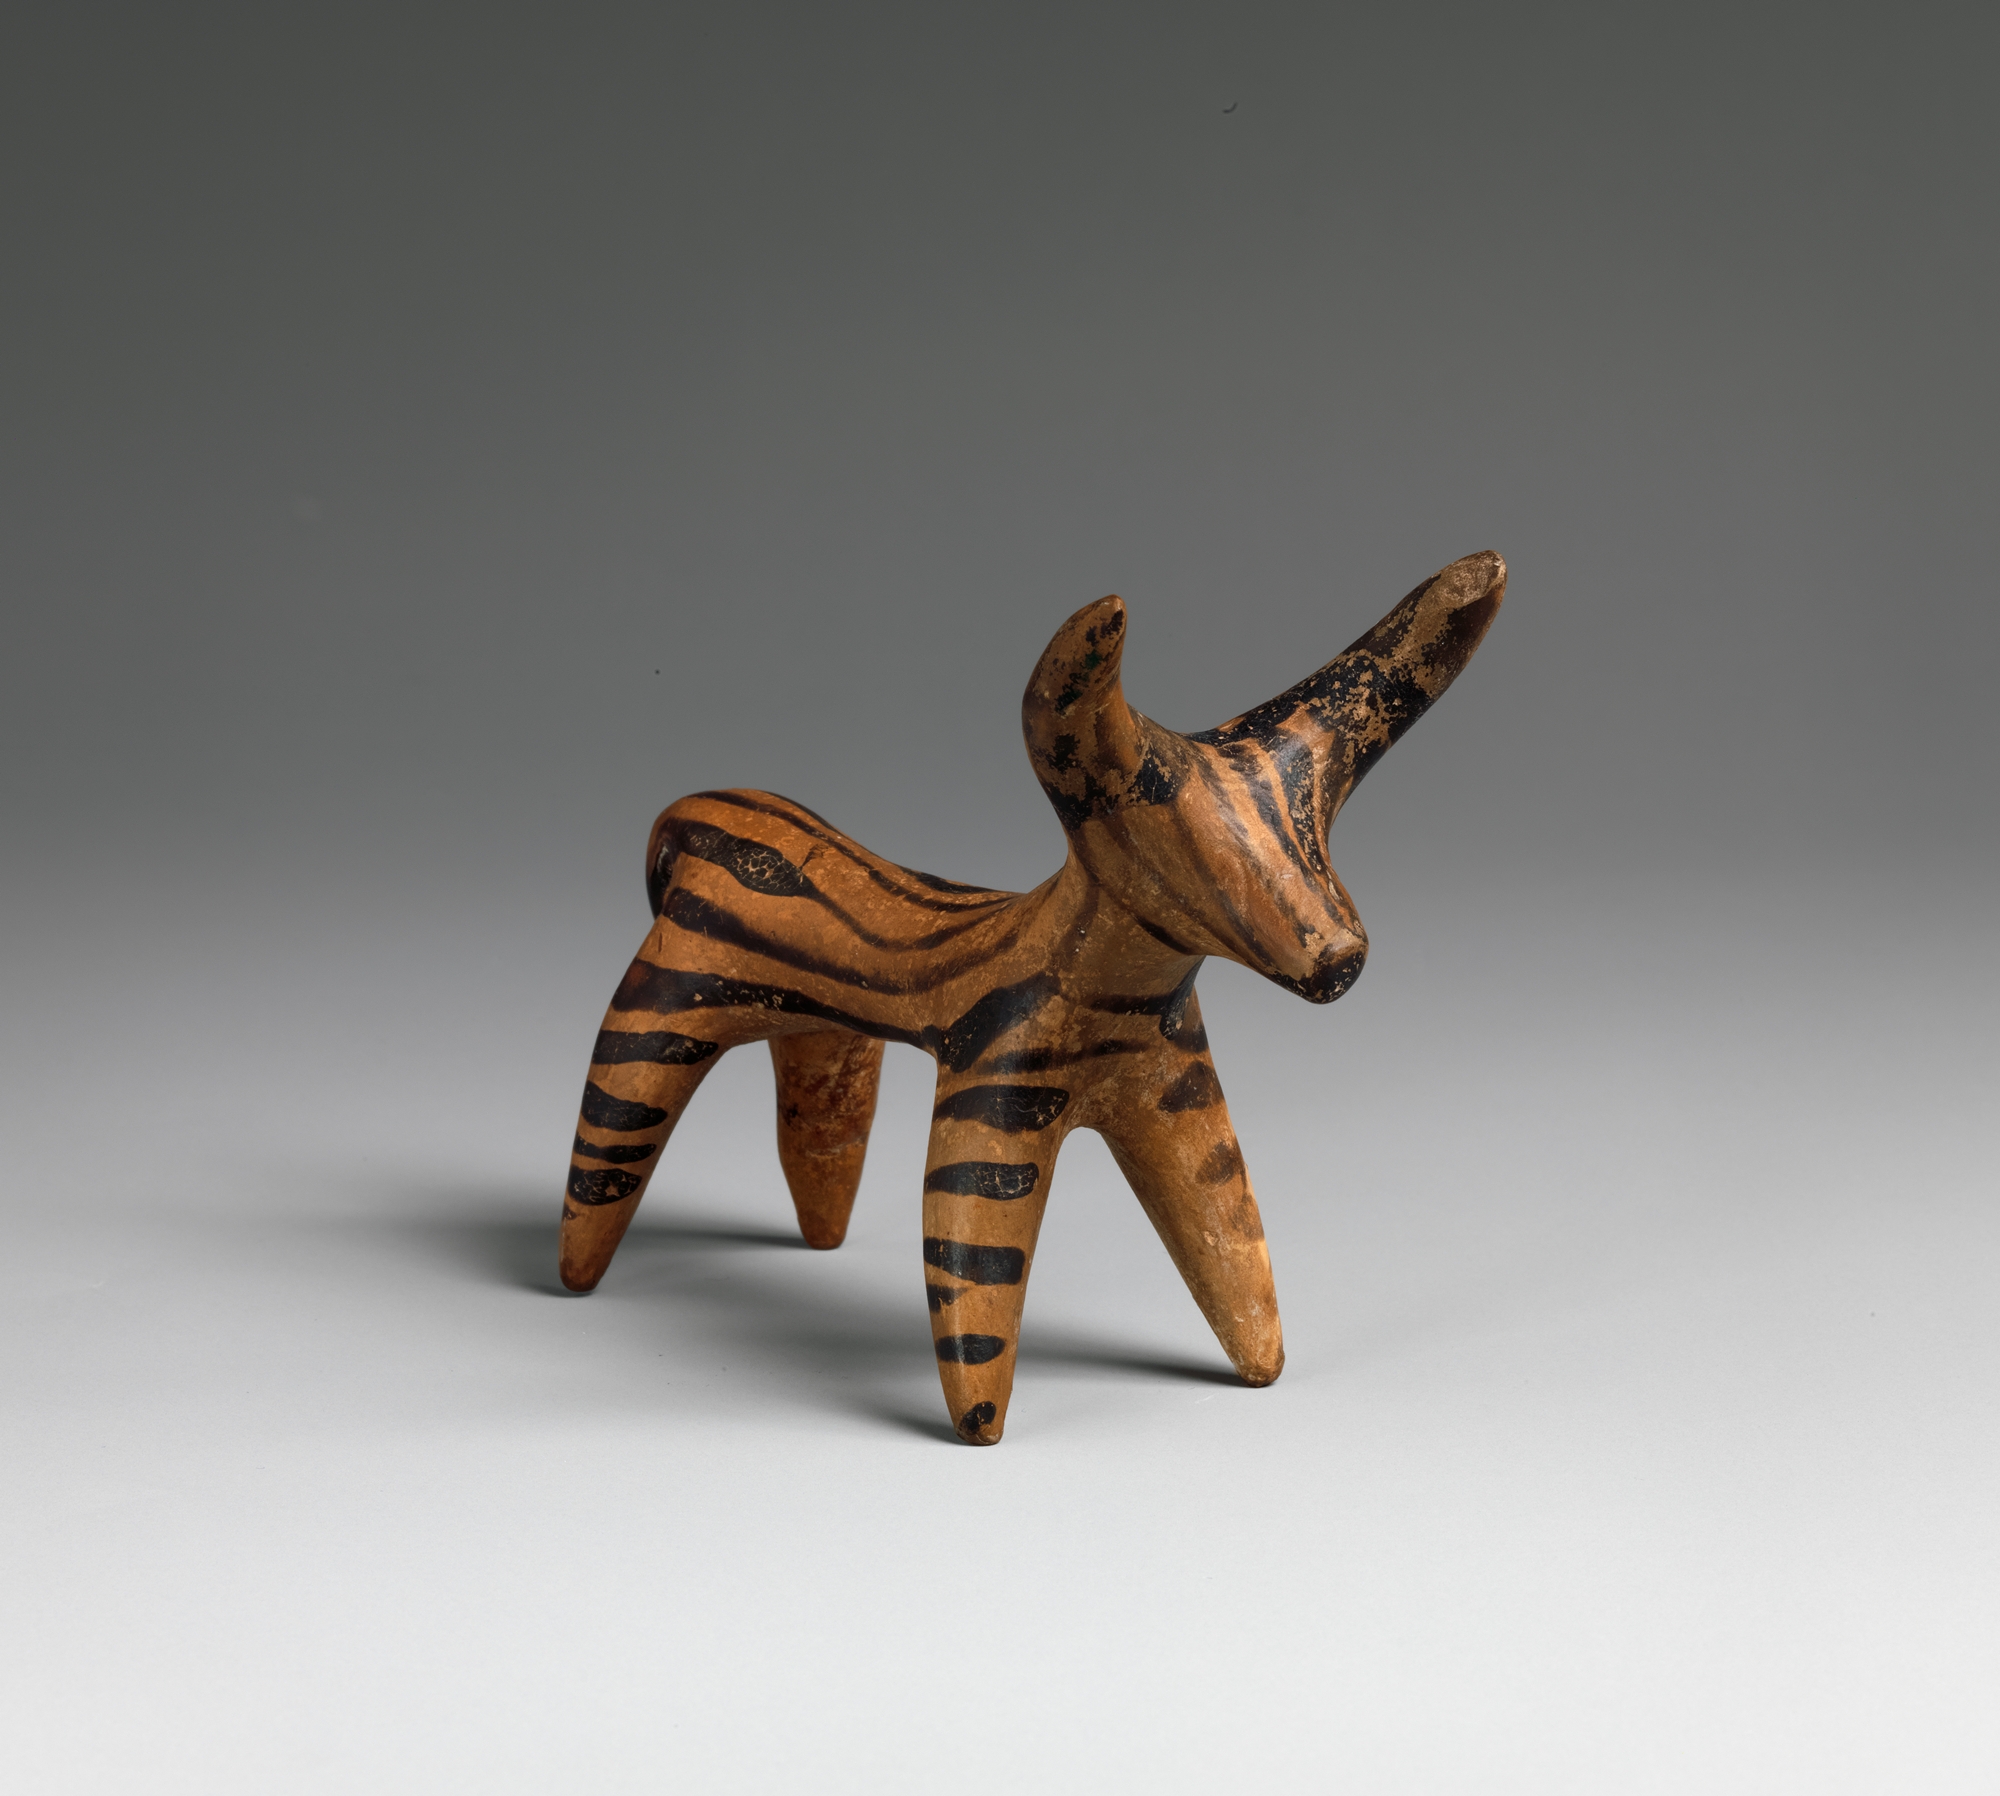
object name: statuette of a bull or ox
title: Terracotta bull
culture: aegean, helladic or mycenaean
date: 1400-1300 BCE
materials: terracotta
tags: bulls